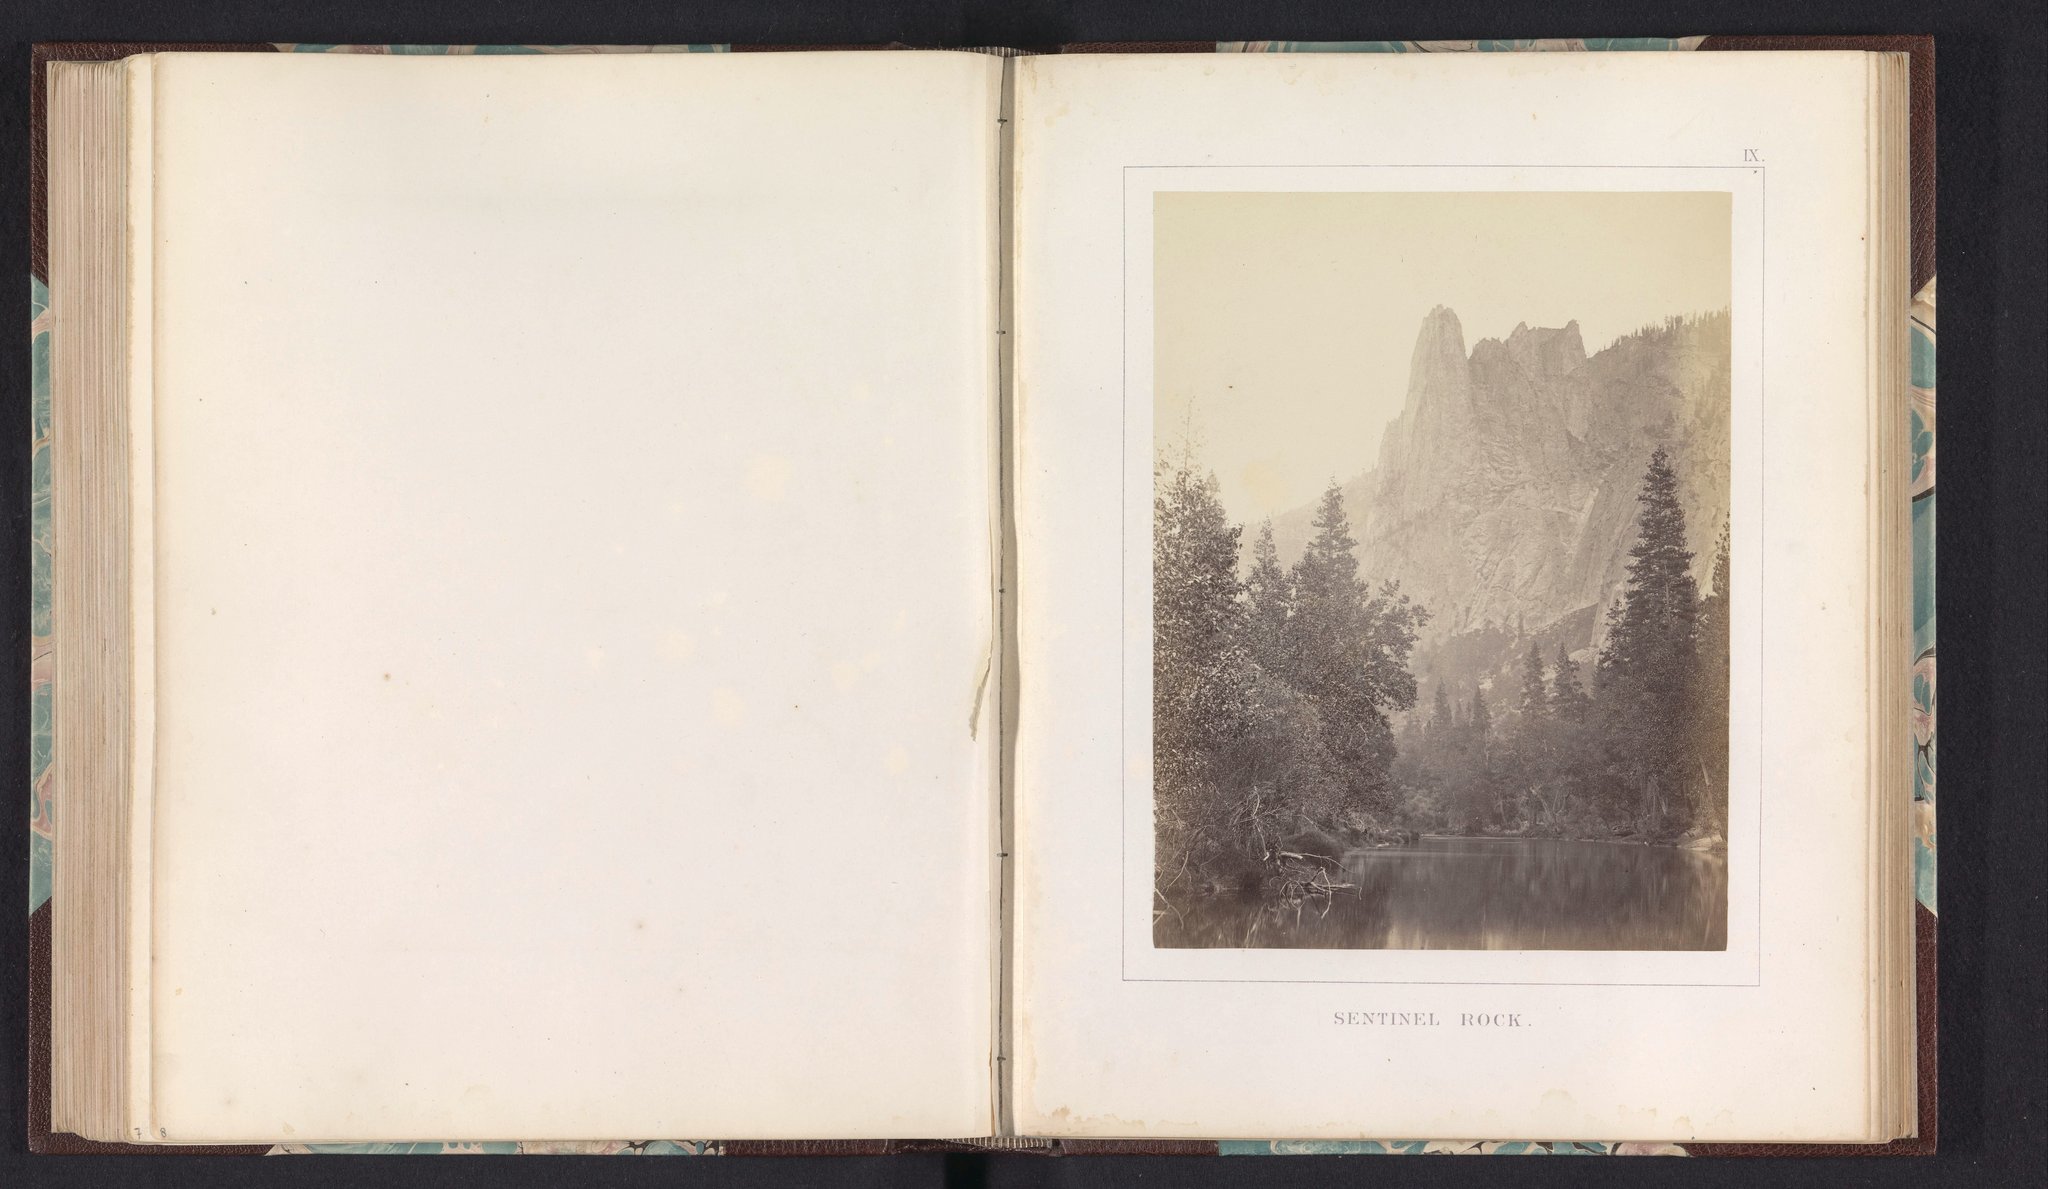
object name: page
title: Sentinel Rock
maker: carleton e. watkins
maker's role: fotograaf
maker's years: 1829-1916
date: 1860-1868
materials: photographic support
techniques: albumen print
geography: yosemite valley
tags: dale, valley, rock-formations, mountains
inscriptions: number: ‘IX.’